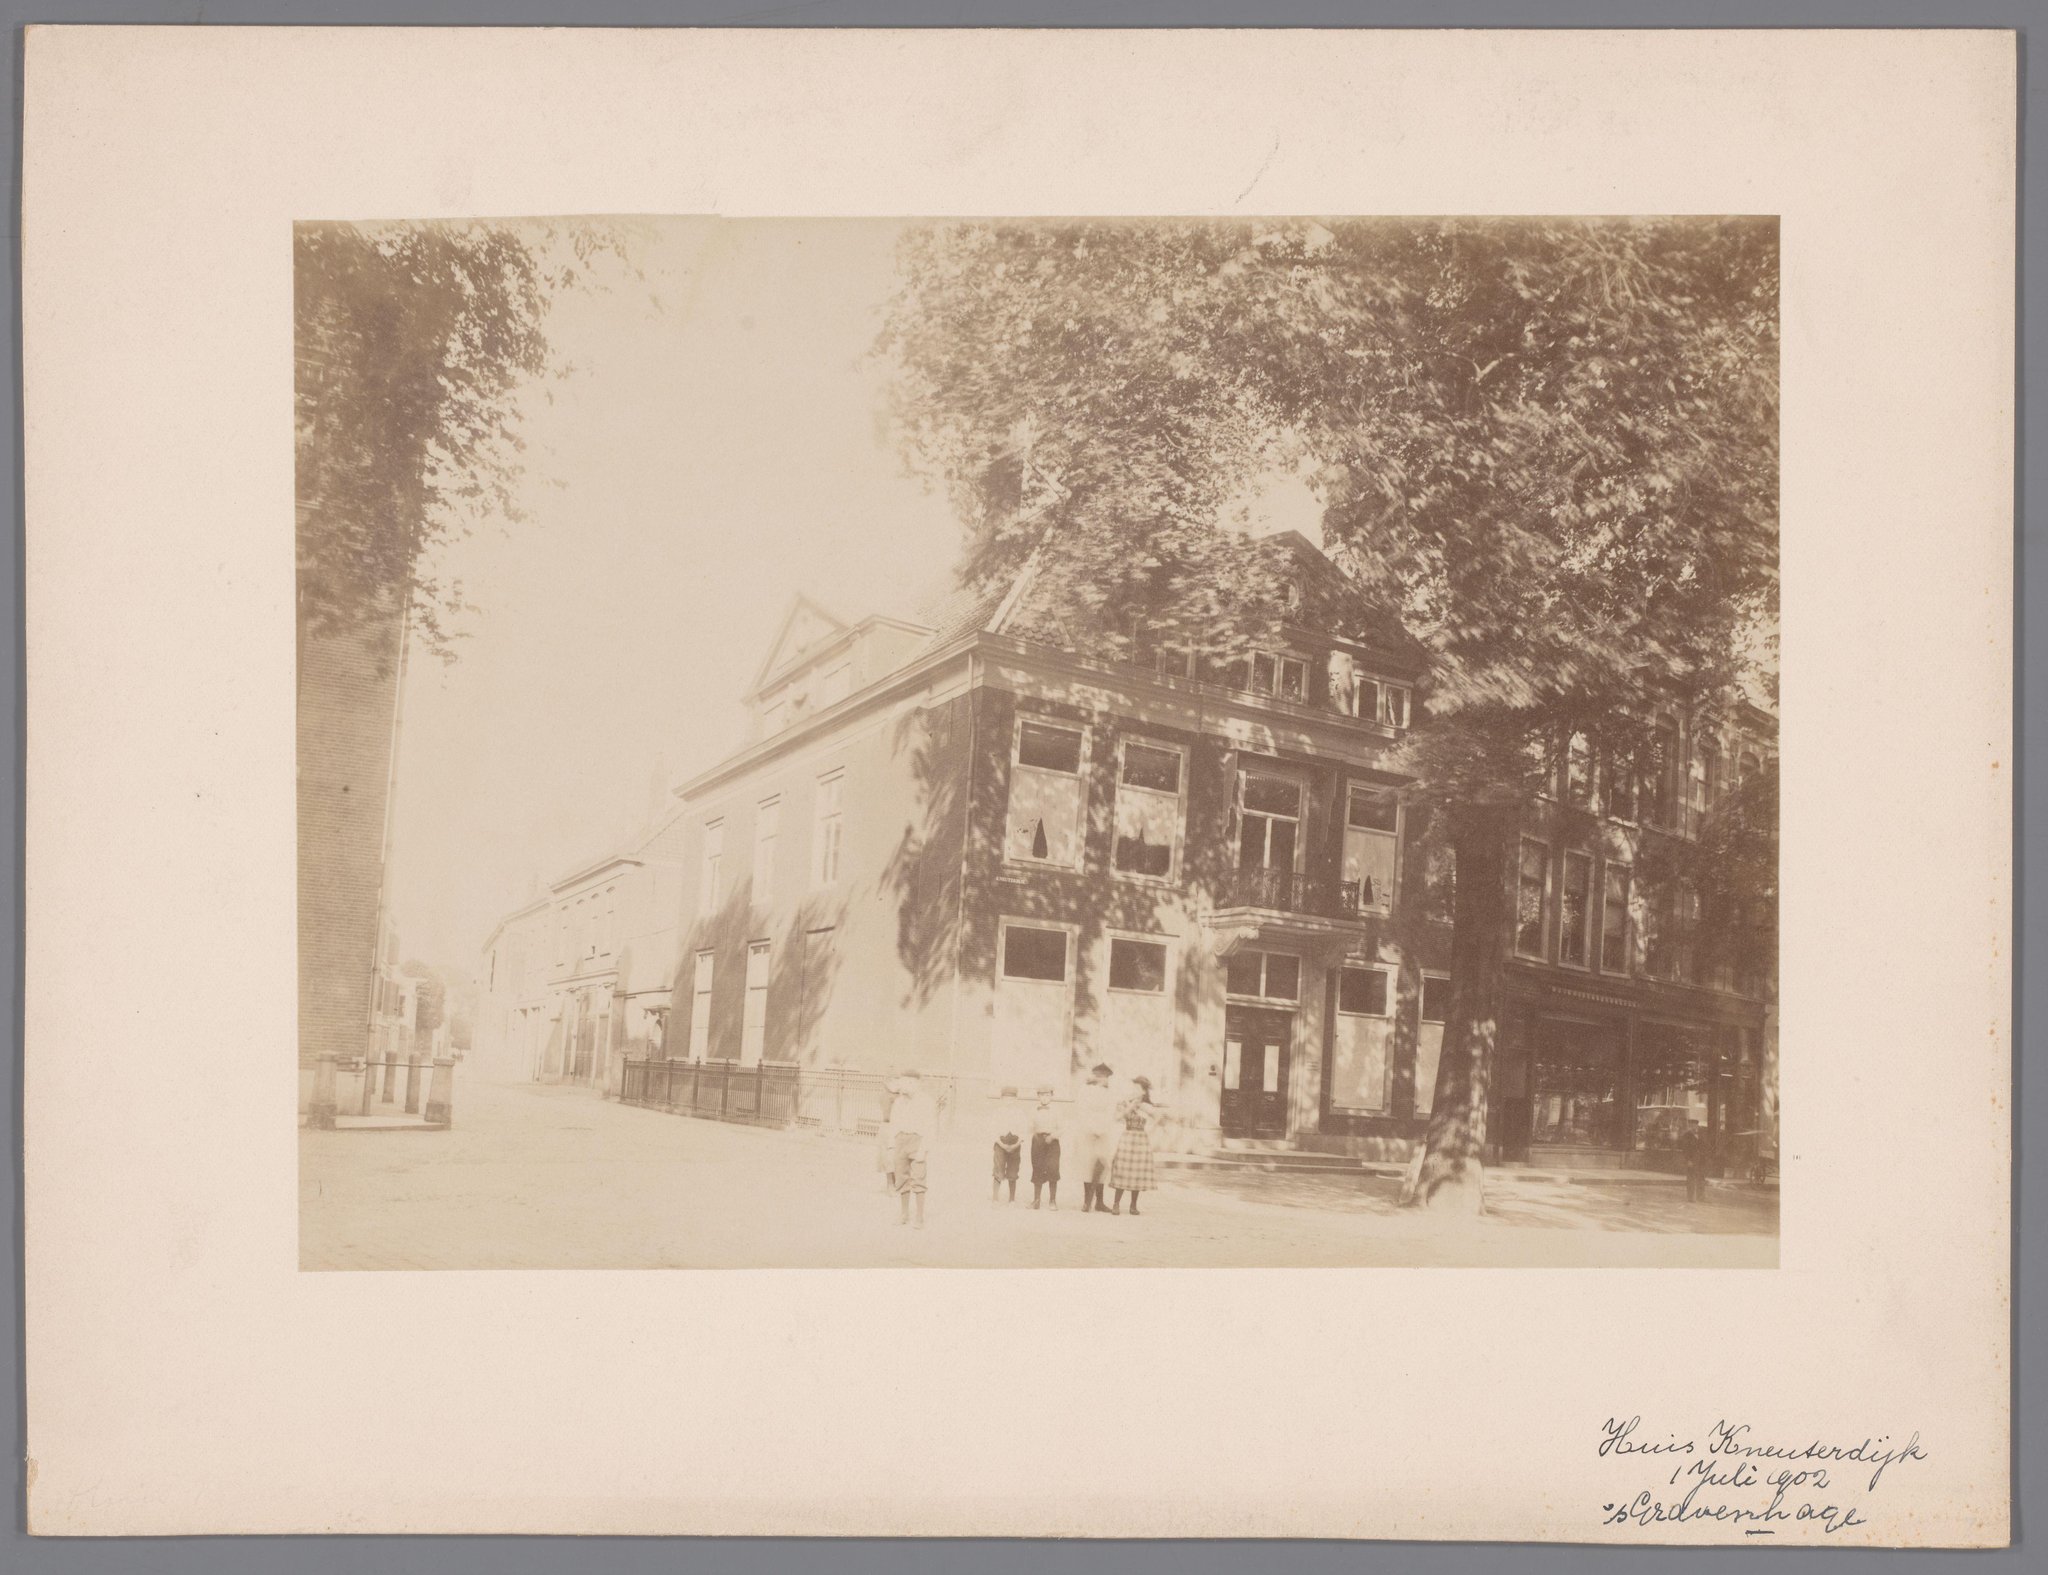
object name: photograph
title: Gezicht op de Kneuterdijk te Den Haag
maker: anoniem (monumentenzorg)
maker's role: fotograaf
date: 1902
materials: cardboard, photographic support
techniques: albumen print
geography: kneuterdijk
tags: urban housing, public road (+ city(-scape) with figures, staffage)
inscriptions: annotation: ‘Huis Kneuterdijk/ 1 Juli 1902/ 's Gravenhage’, collector's mark: ‘R:MUS.’ Lugt 2228, annotation: ‘'s Gravenhage/ Huis No. Kneuterdijk/ 1 Juli 1902’